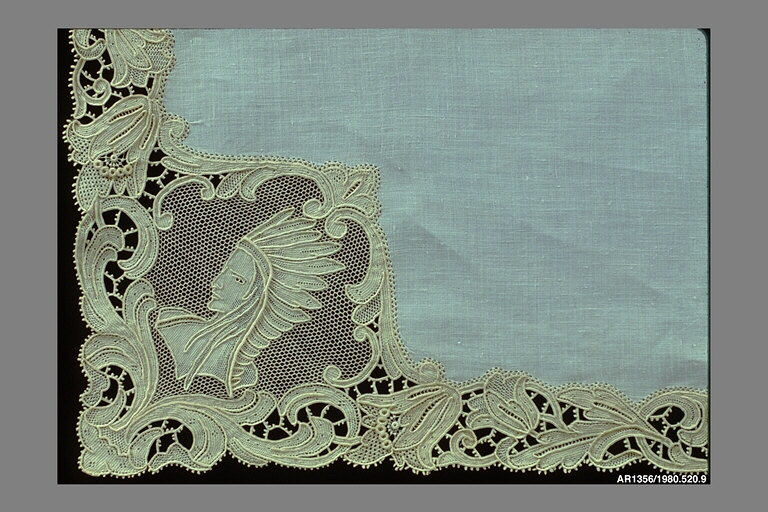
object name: napkin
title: Napkin (from a set of table linens)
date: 1867-1900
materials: linen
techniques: lace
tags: profiles